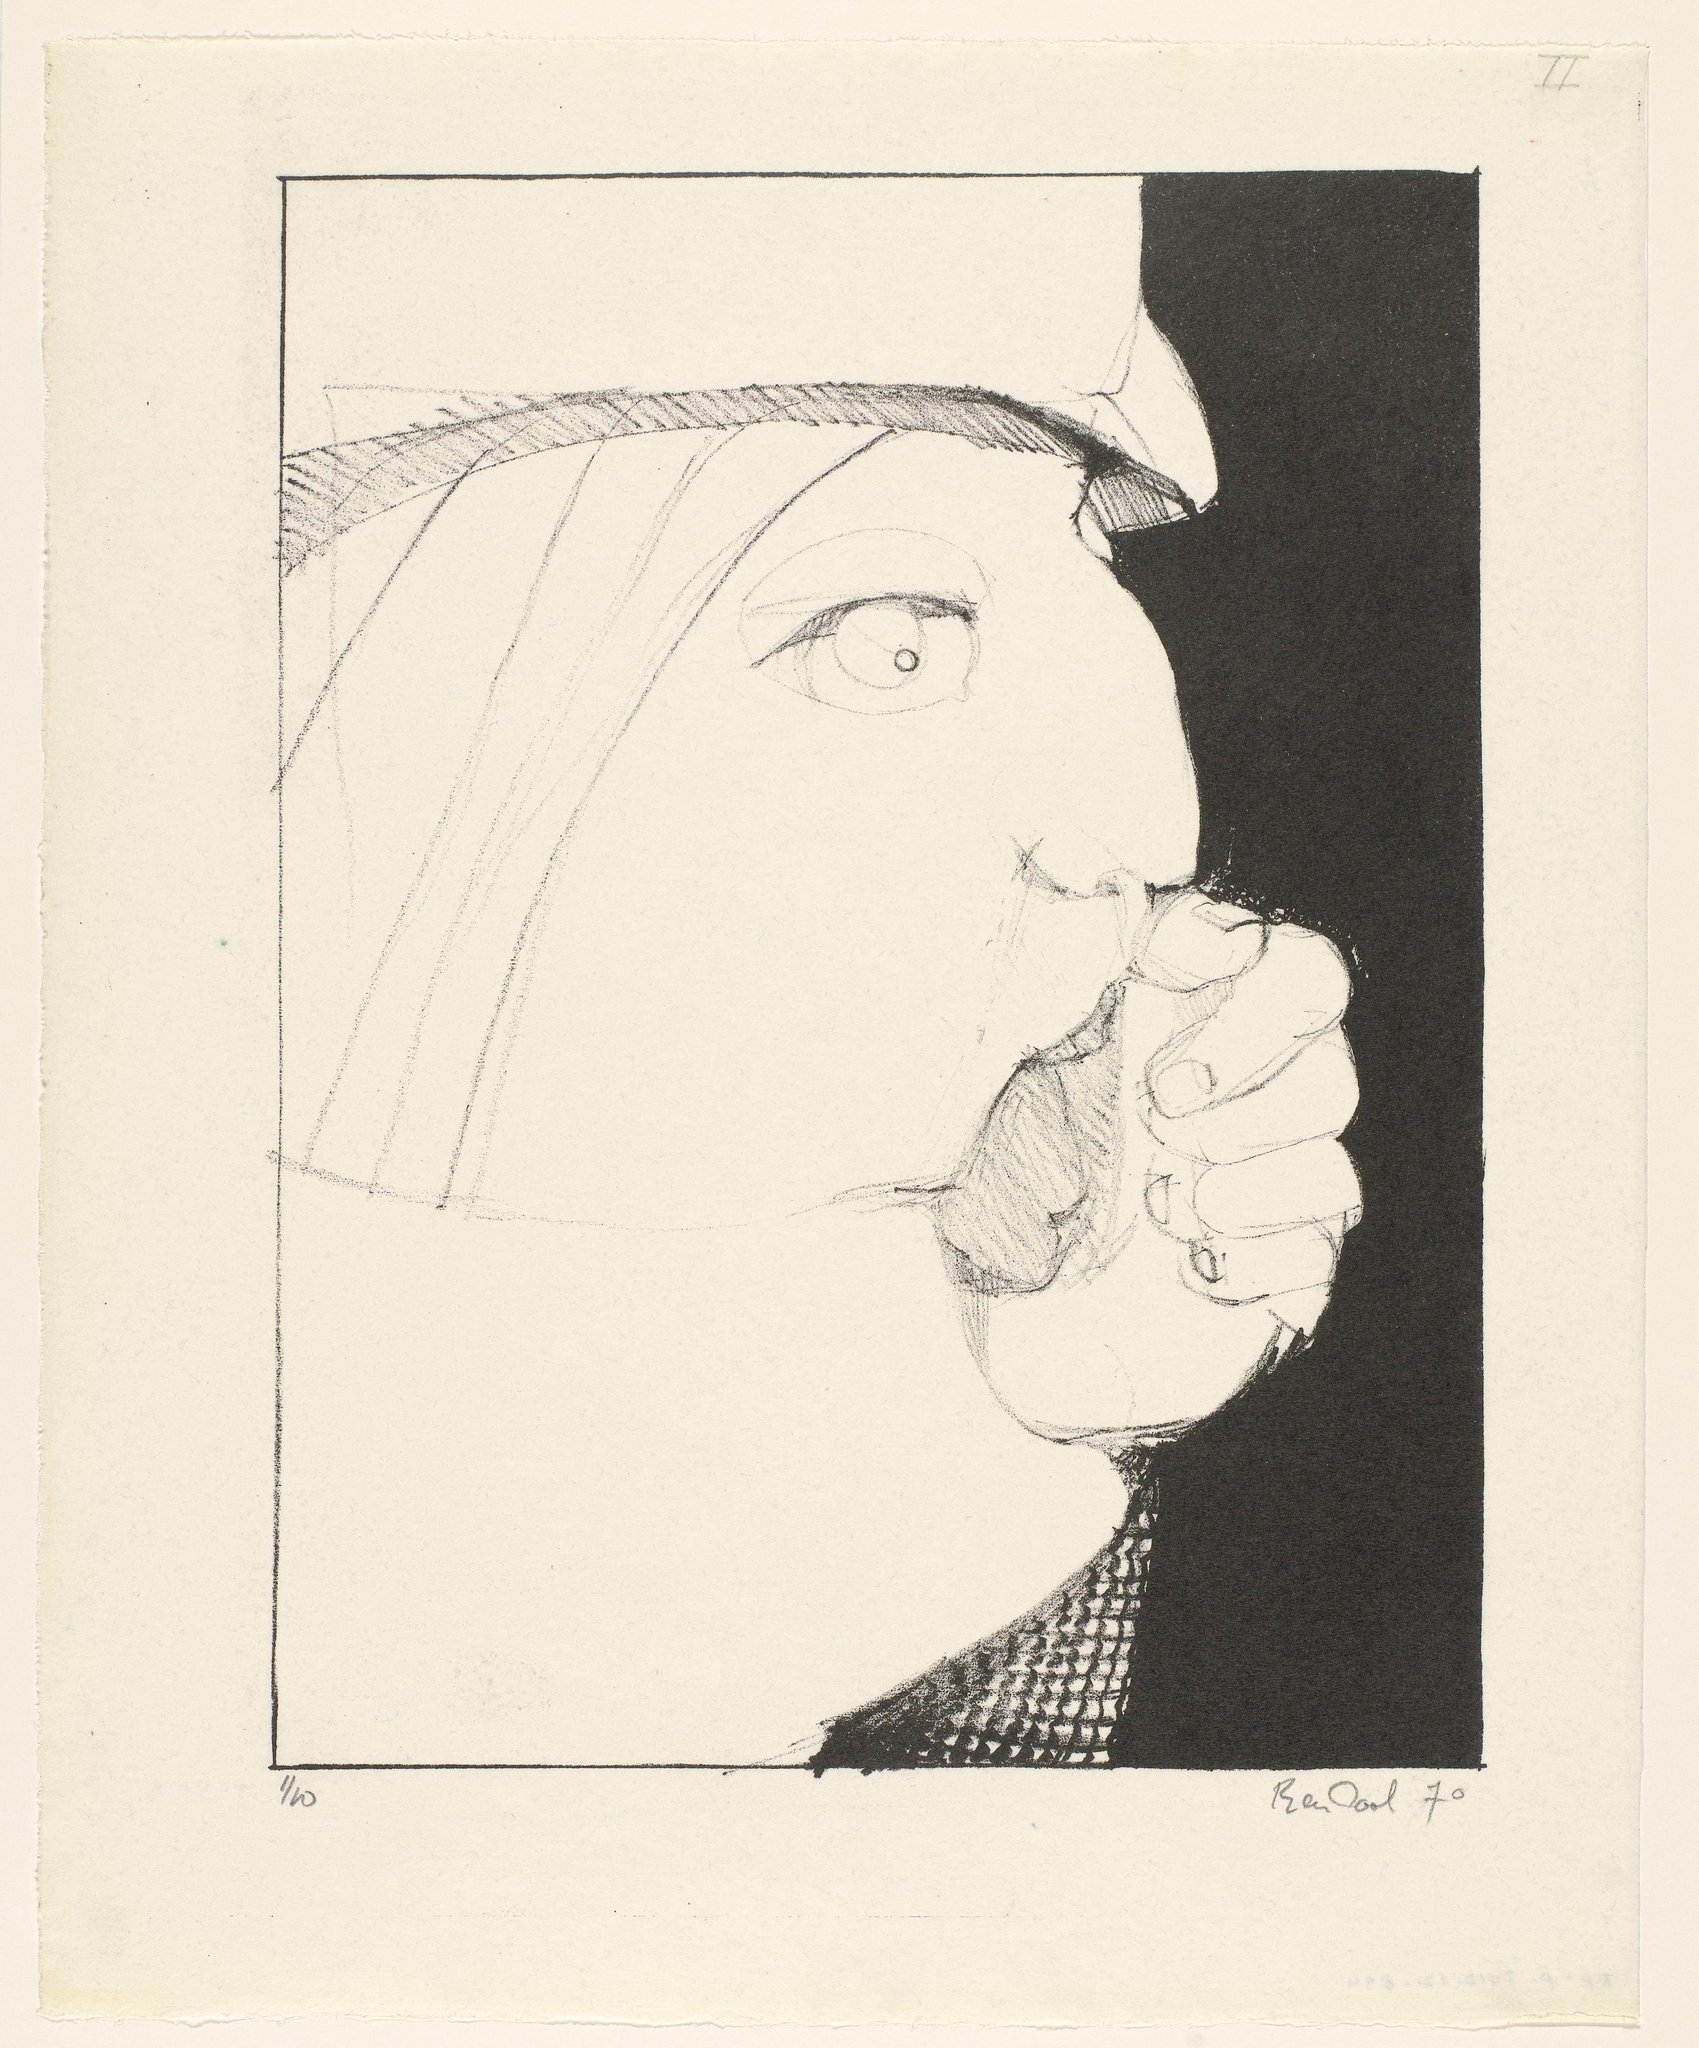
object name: print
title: Vrouw etend van vrucht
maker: rein dool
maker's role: draughtsman, painter, print maker, sculptor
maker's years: 1933-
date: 1970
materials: paper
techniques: lithograph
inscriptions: signature and date: ‘Rein Dool 70’, edition: ‘1/10’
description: Vrouw etend van vrucht tegen zwarte achtergrond.